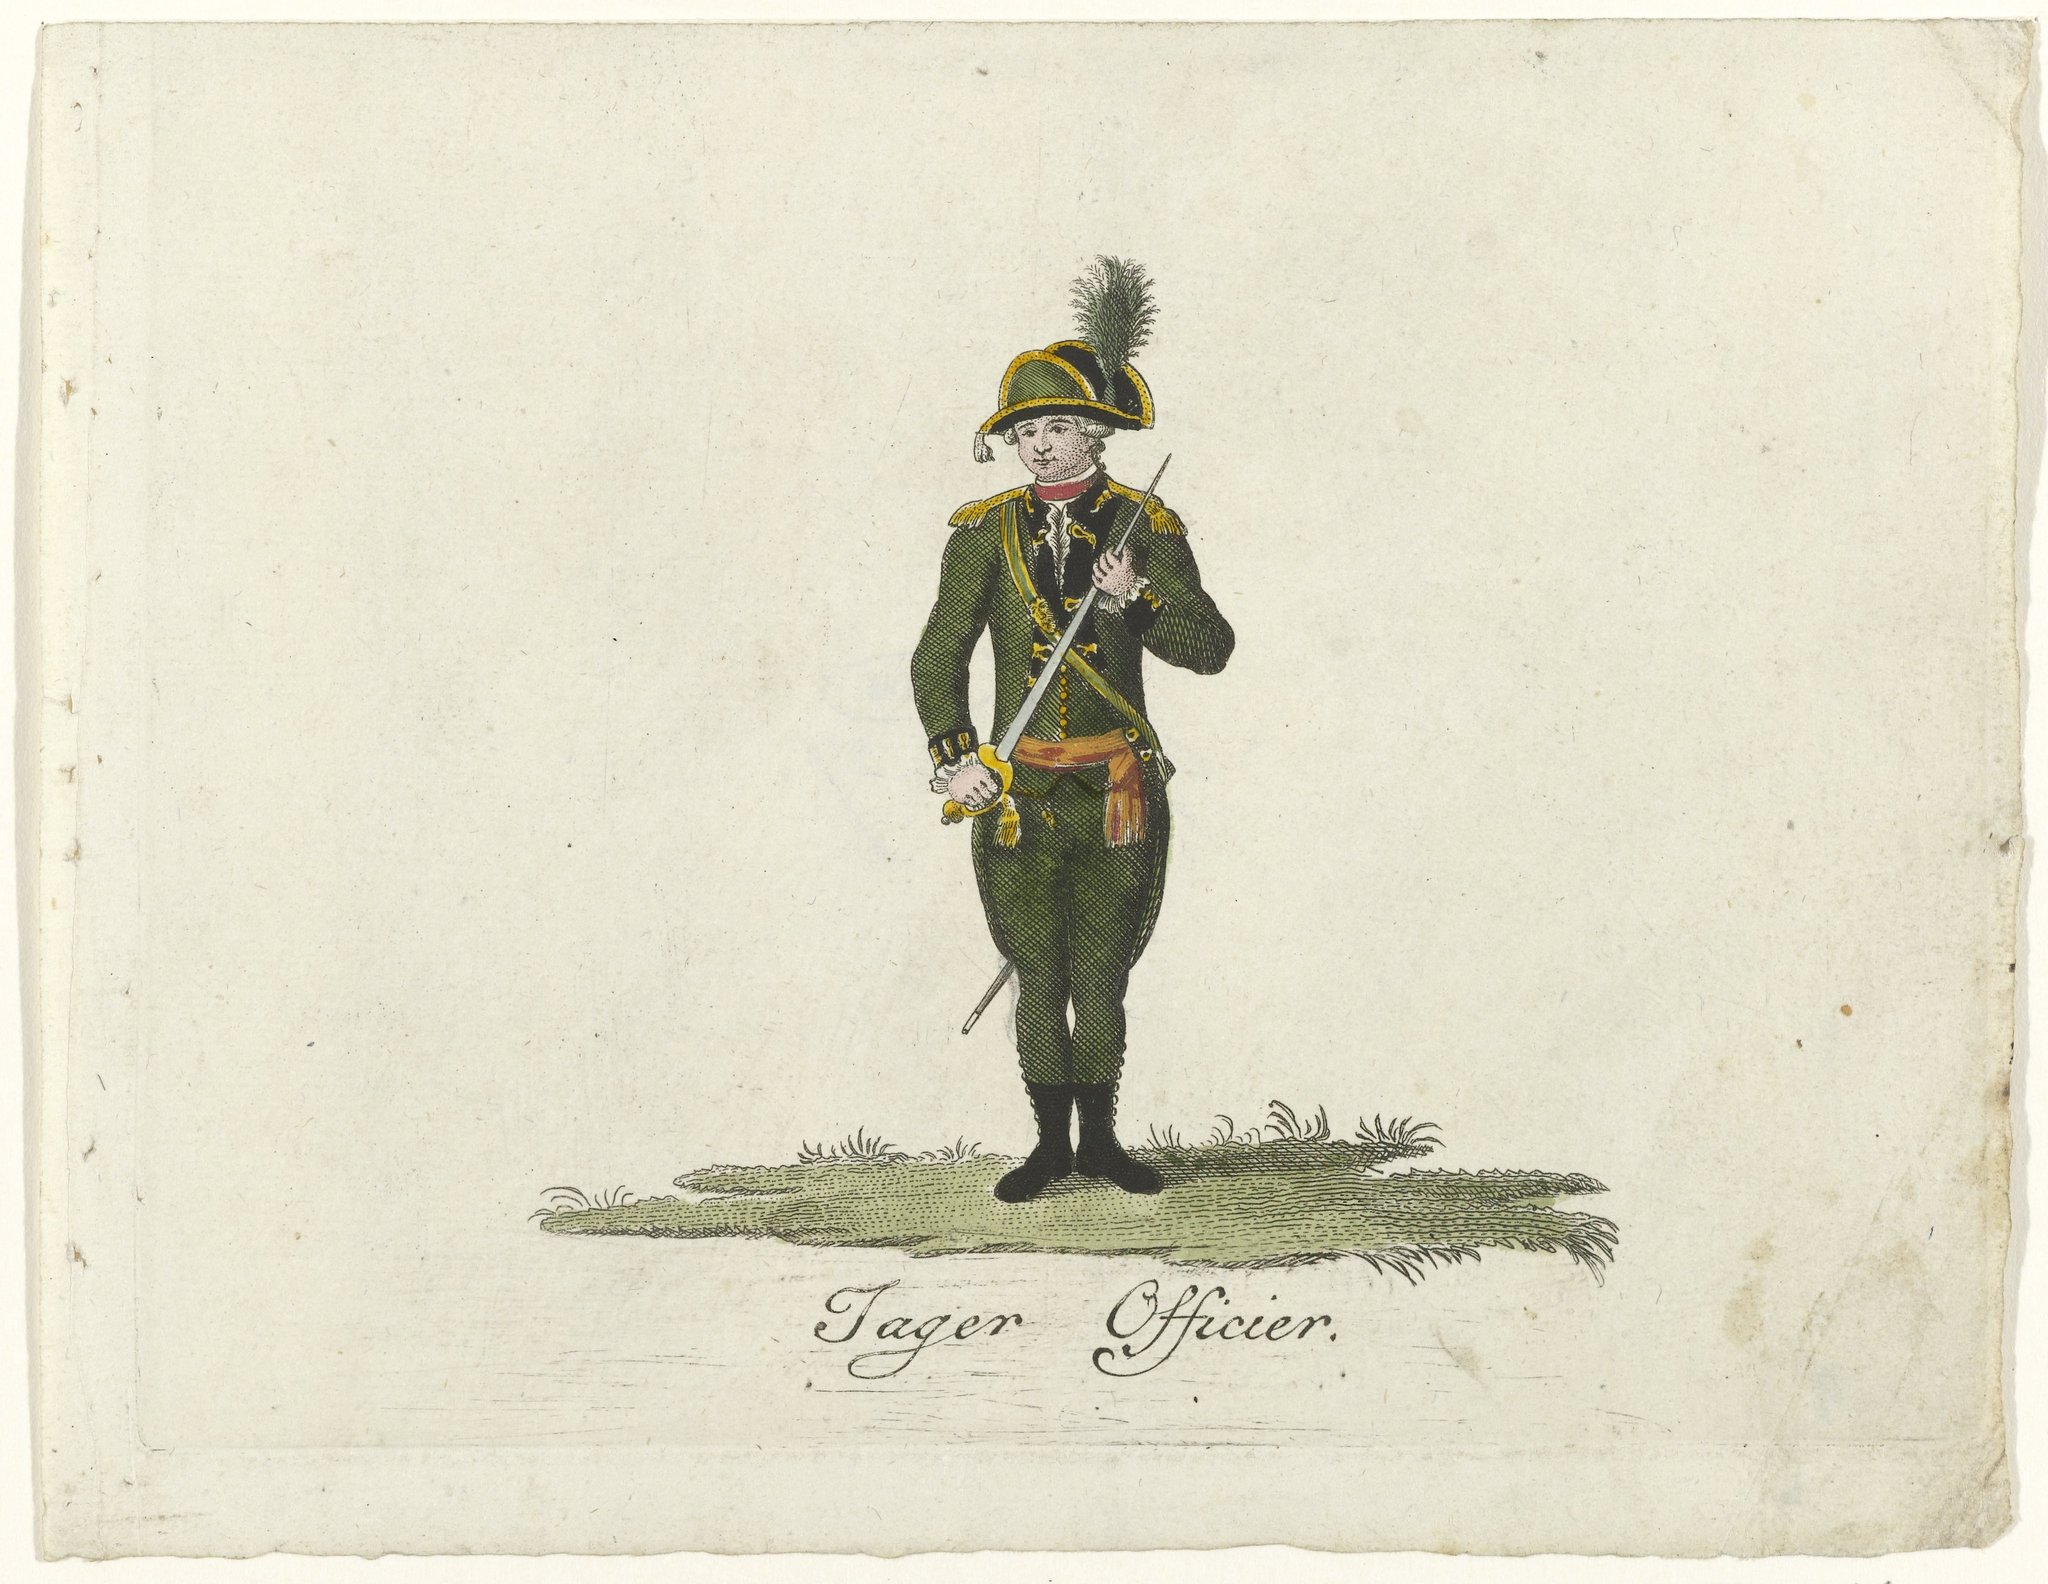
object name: print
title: Uniformen van het legioen van de Rijngraaf van Salm, 1785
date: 1785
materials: paper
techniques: etching, hand coloring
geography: utrecht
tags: rijngraaf van salm frederik iii, (military) uniforms (+ infantry), patriots (1780-1795)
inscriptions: collector's mark: Lugt 2228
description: Staande jager in uniform. Onderdeel van de prentserie van uniformen van het legioen van Frederik III Rijngraaf van Salm, in dienst van Republiek in 1785.